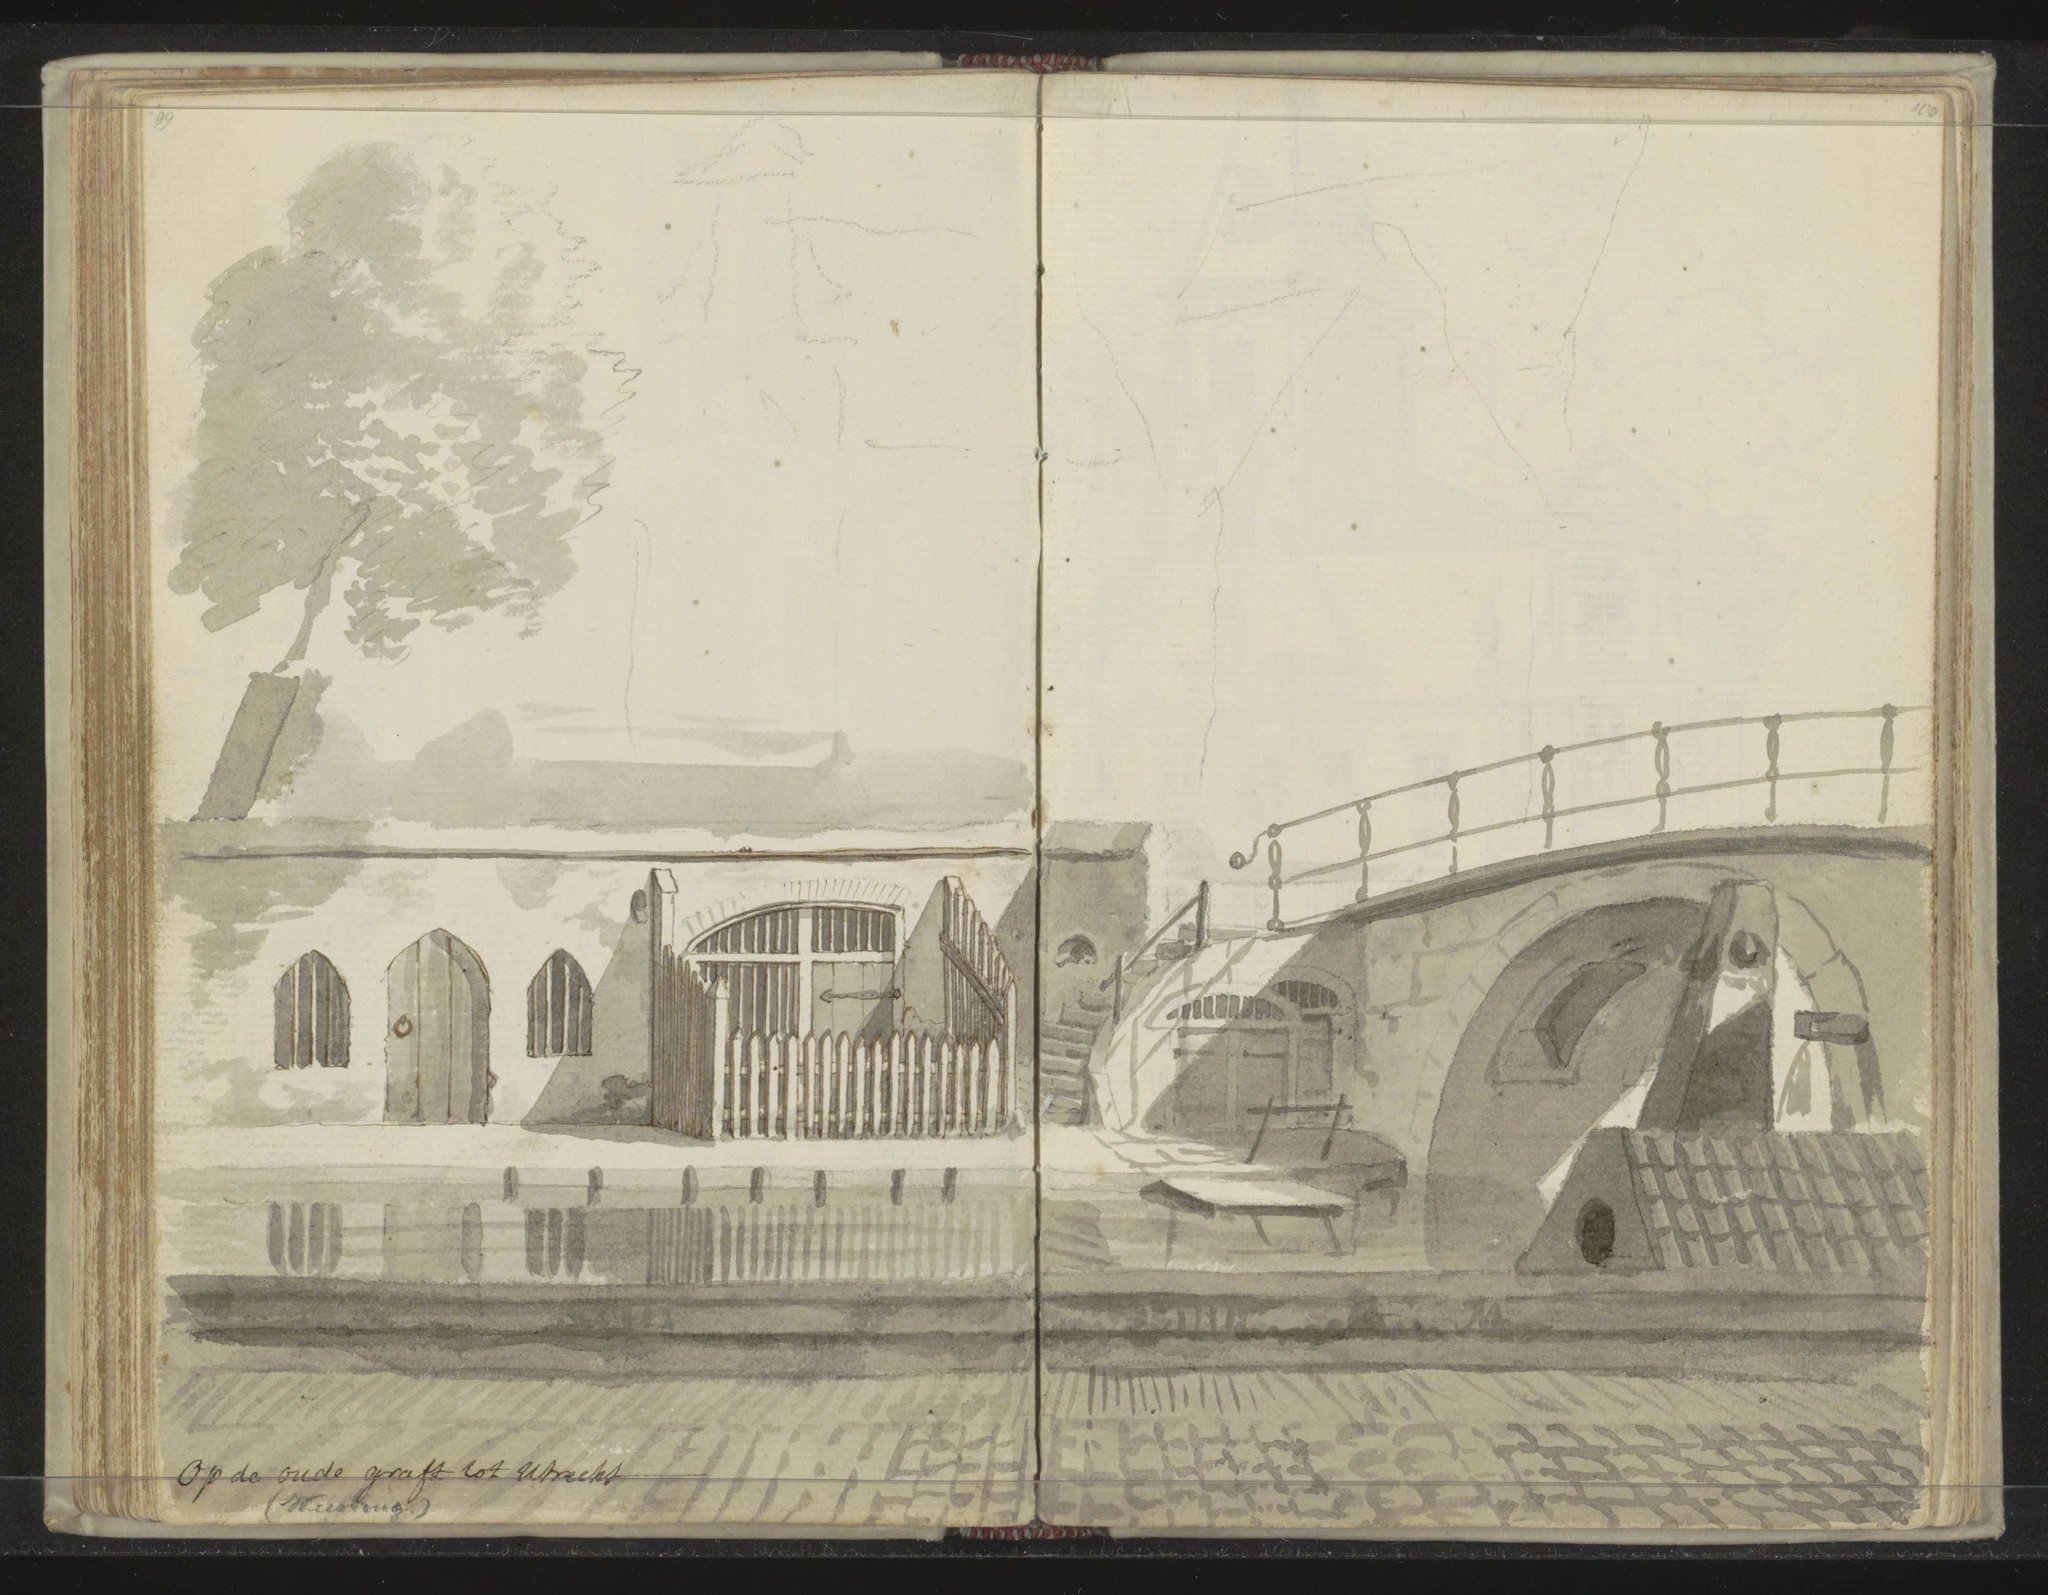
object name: sketchbook leaf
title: Weesbrug over de Oudegracht te Utrecht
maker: johannes huibert prins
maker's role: draughtsman, painter, print maker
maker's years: 1757-1806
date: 1783-1797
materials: ink, paper, pencil, watercolor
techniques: brush, pen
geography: utrecht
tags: canals, waters (in city)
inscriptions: annotation: ‘Op de oude graft tot Utrecht/ (Weesbrug)’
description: Pagina 99 en 100 uit een schetsboek met 175 pagina's.